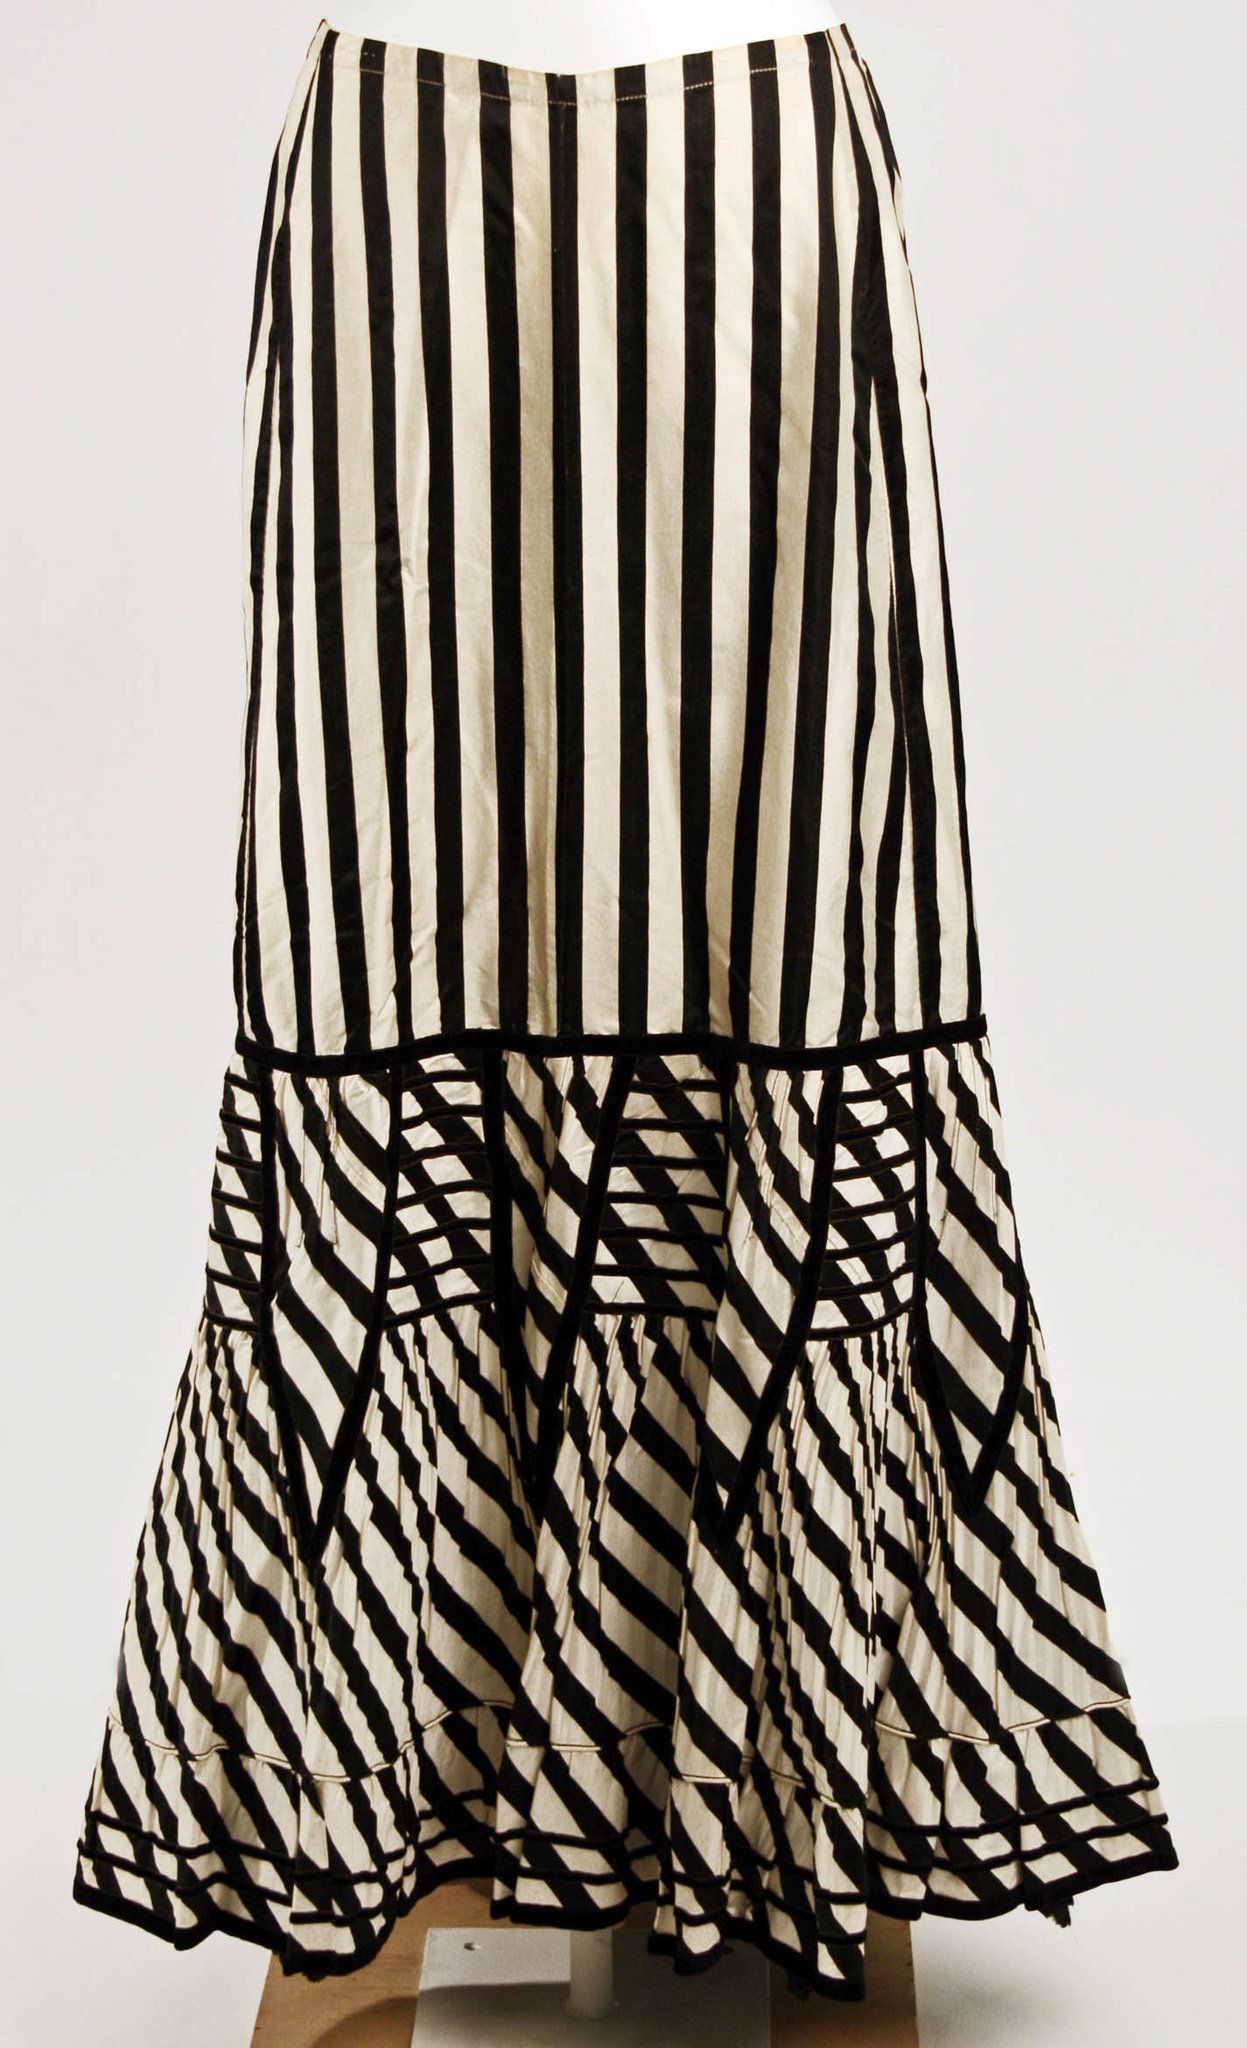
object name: underskirt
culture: american or european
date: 1900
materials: silk